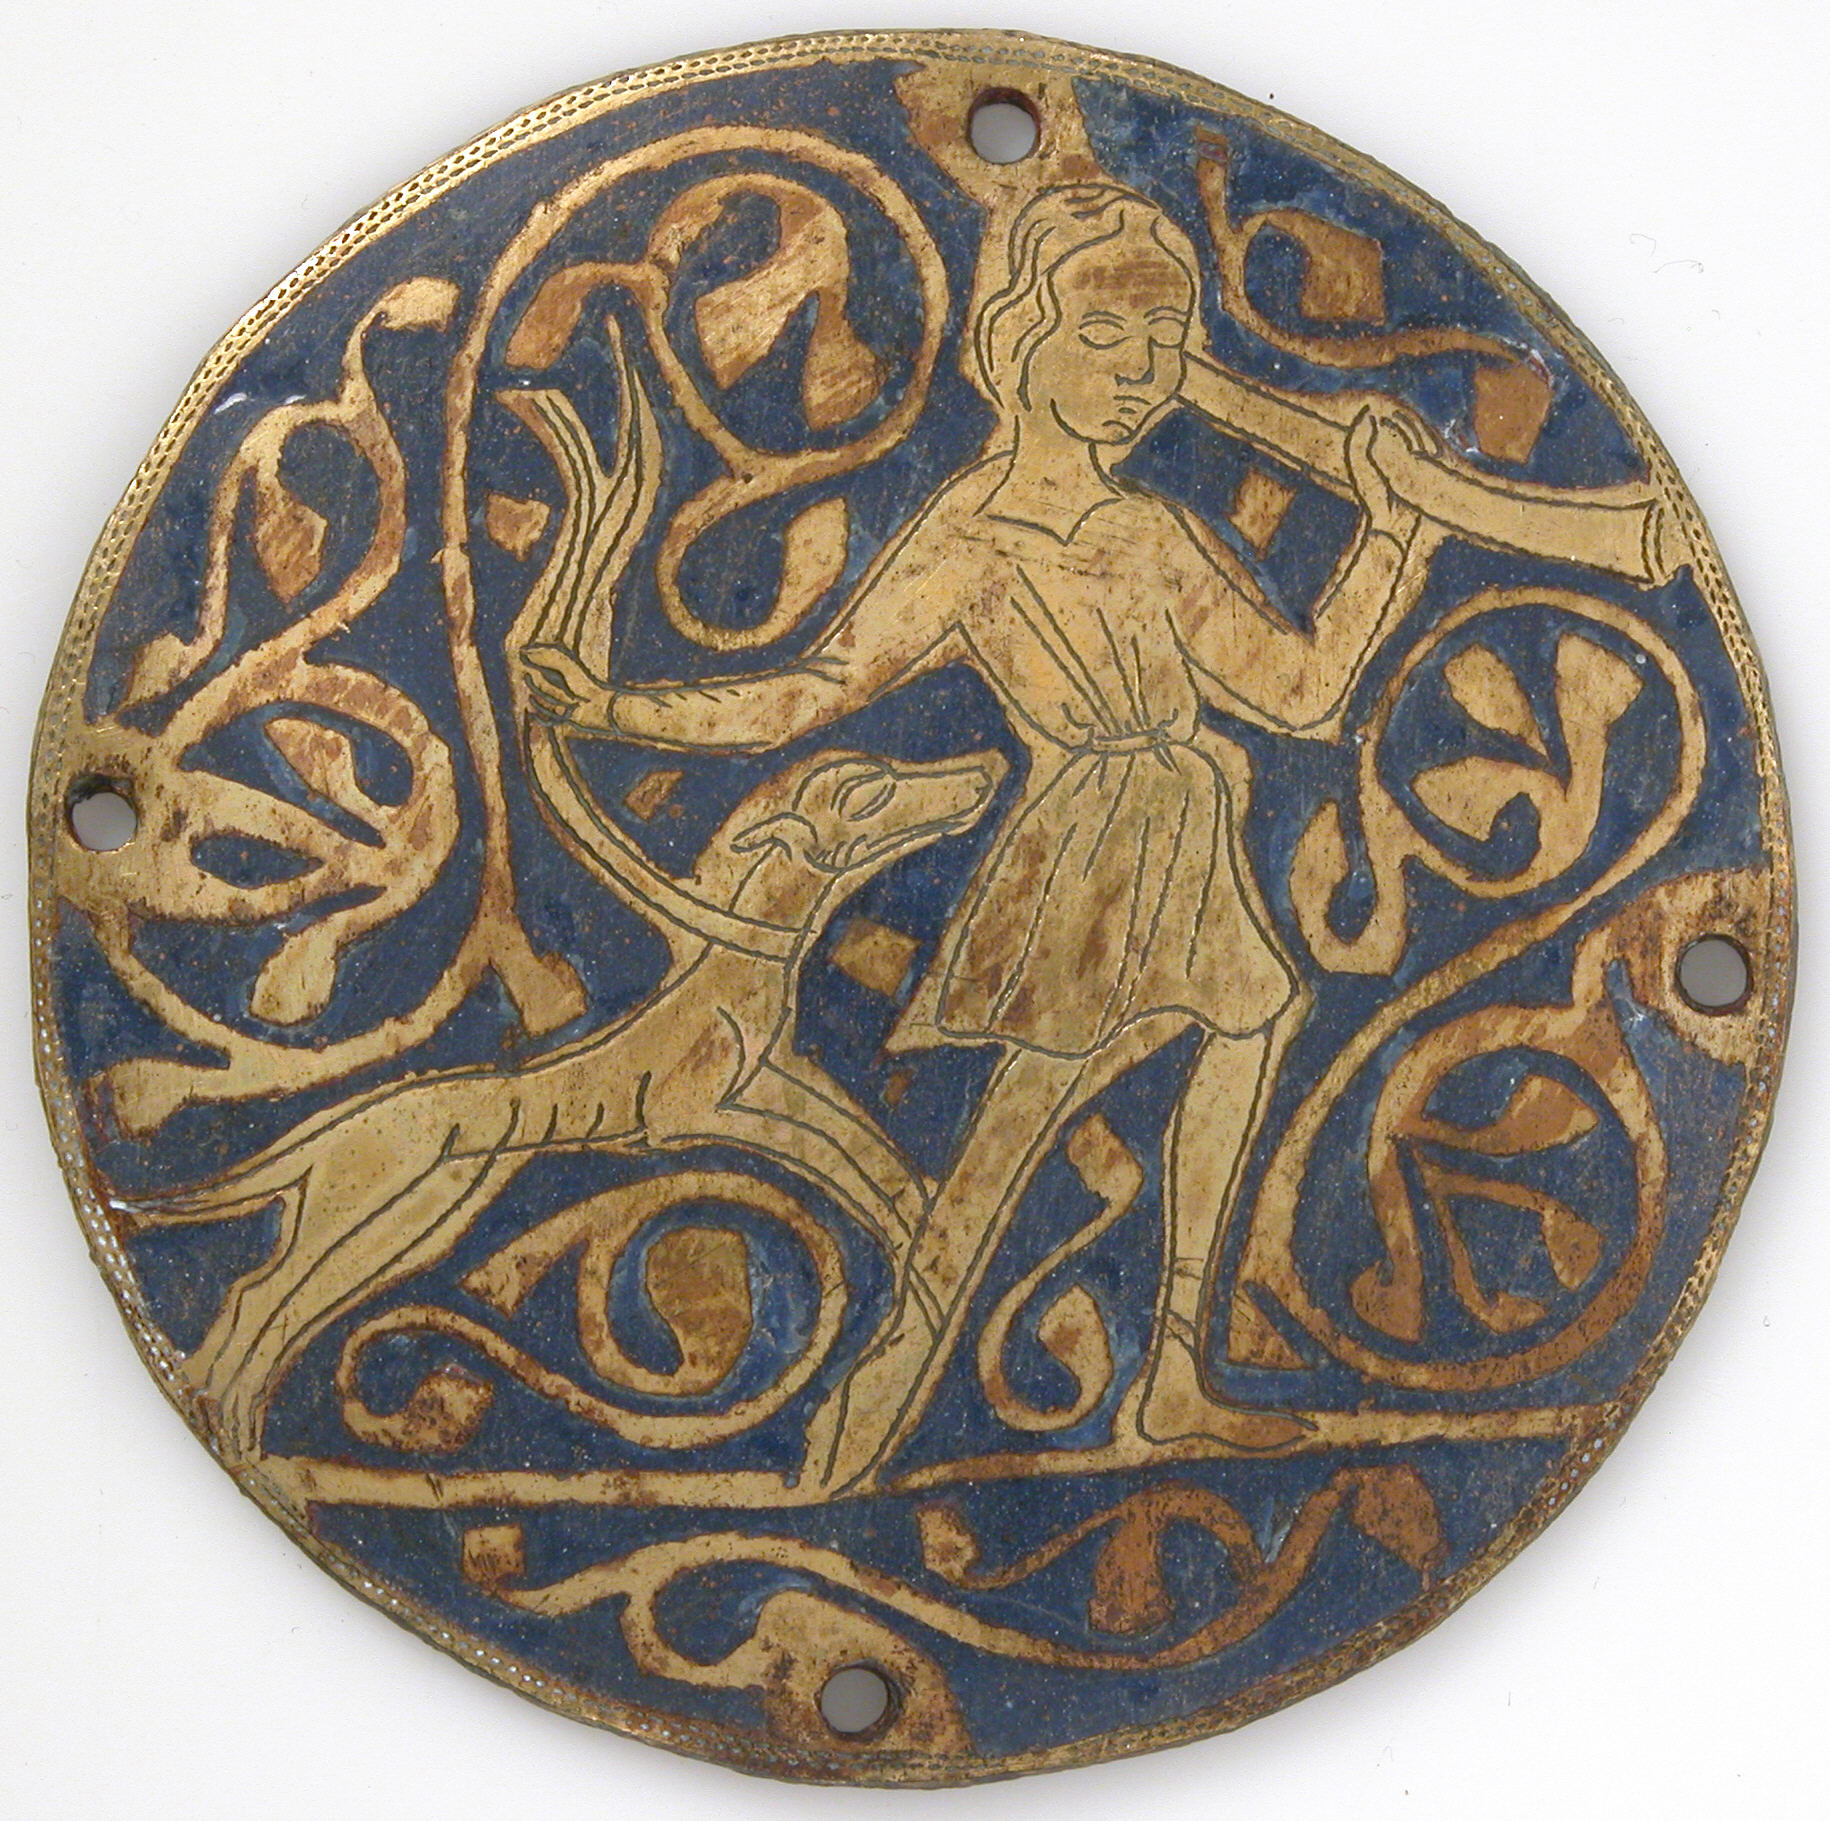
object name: medallion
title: Medallion with Varlet with Horn and Hound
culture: french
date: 1240-1260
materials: copper, enamel, gilt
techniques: enamel, engraving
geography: france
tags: boys,horns,dogs